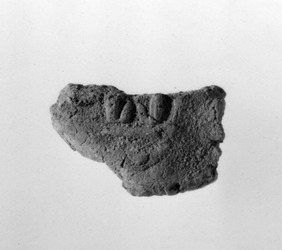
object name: sealing, nebmaatre, amenhotep iii, horus, re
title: Document Sealing With the Throne Name of Amenhotep III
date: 1390-1352 BCE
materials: mud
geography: egypt